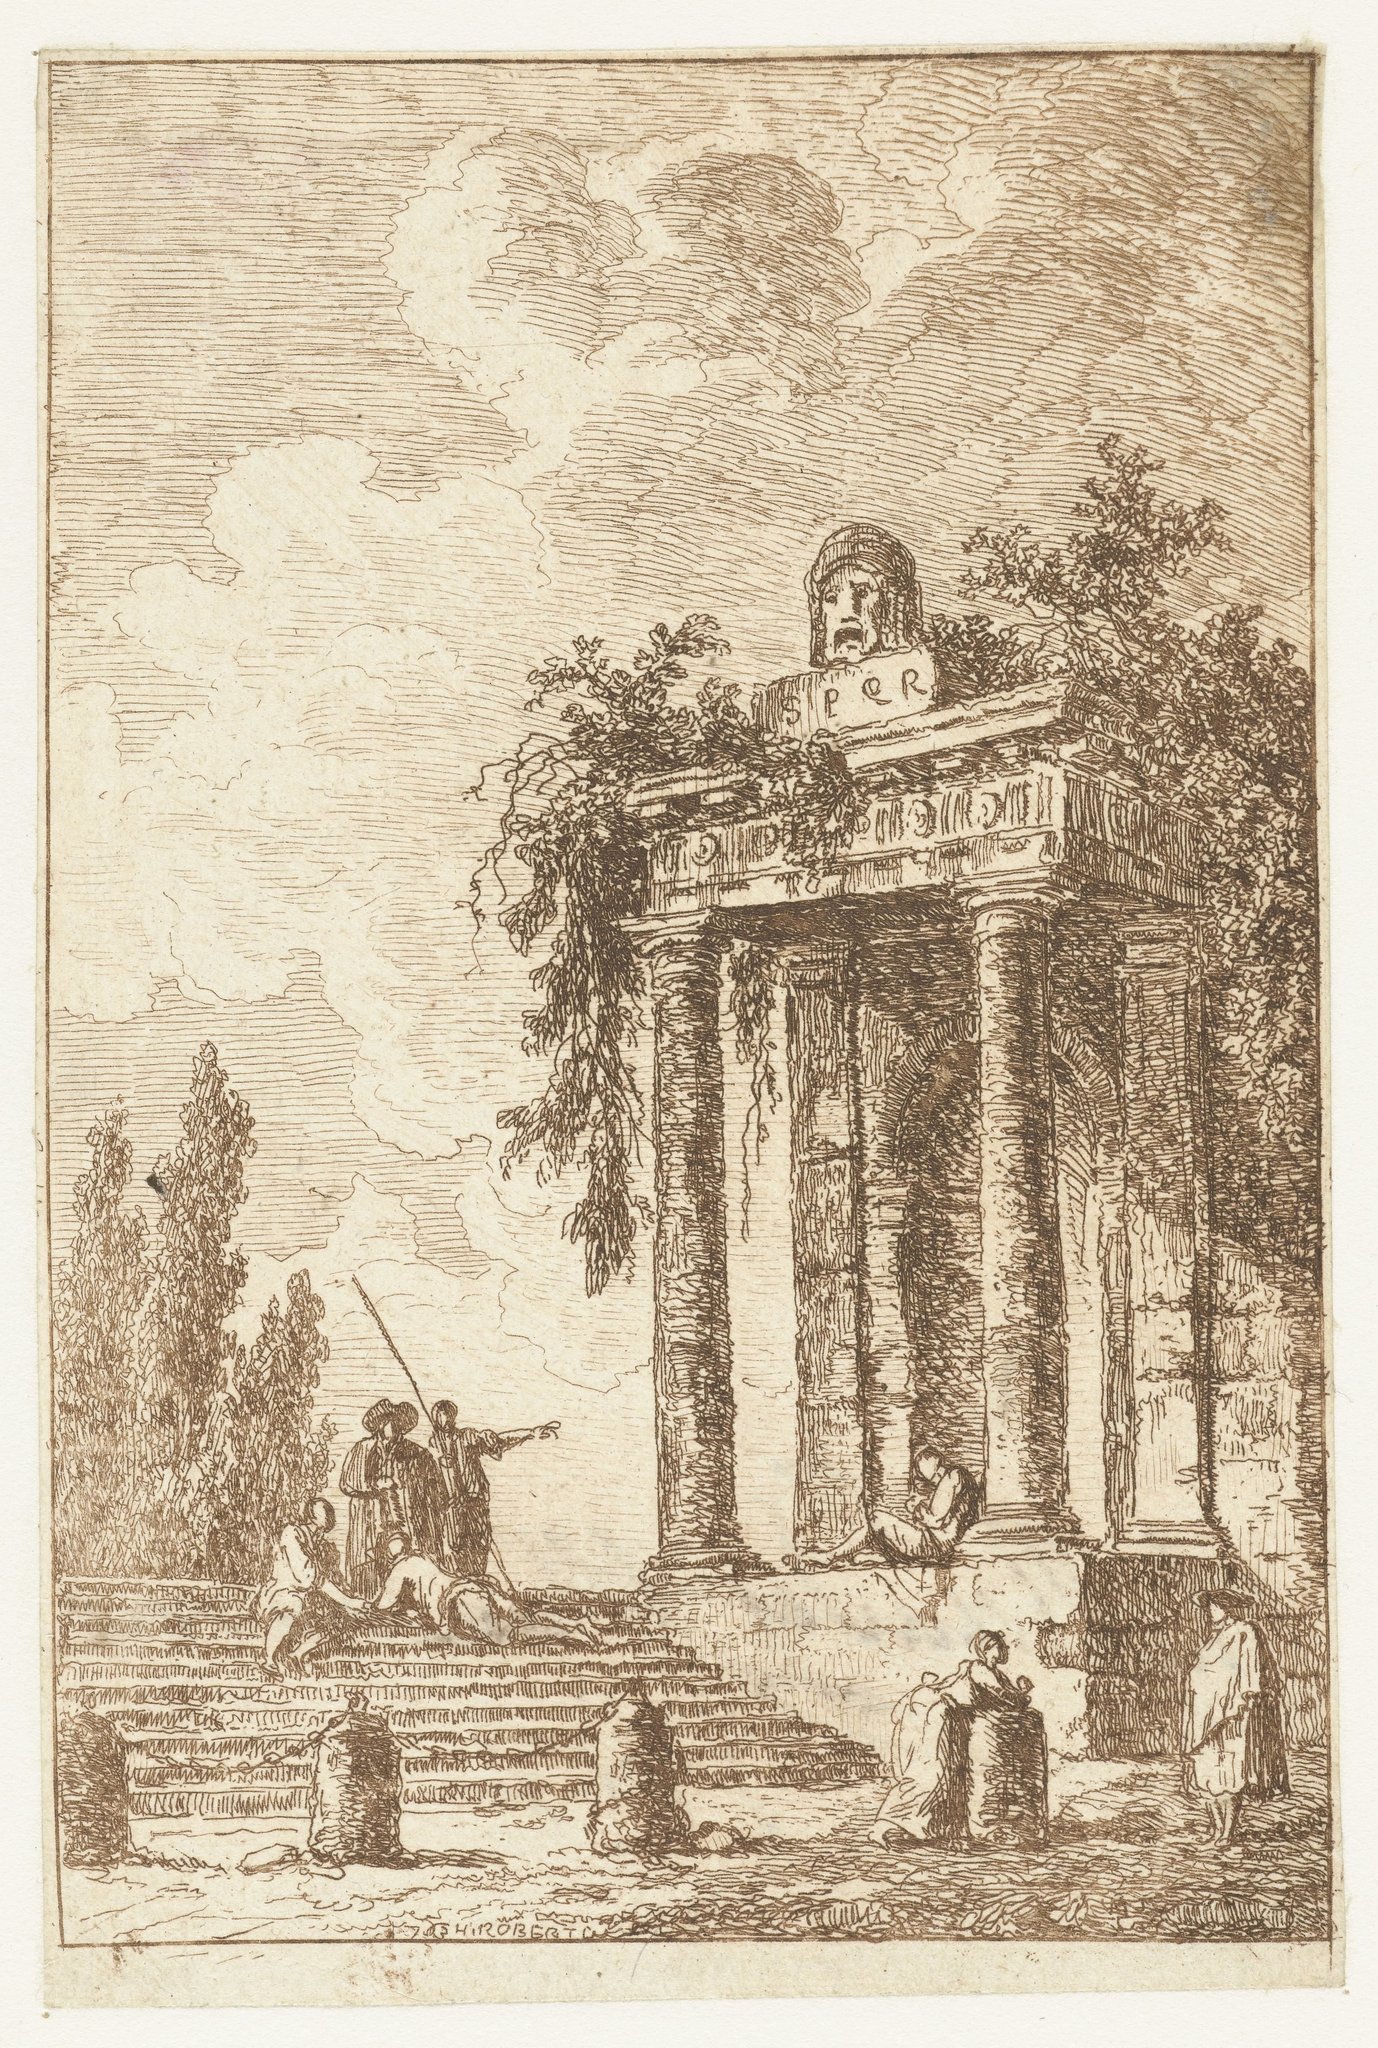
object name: print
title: Romeinse gezichten`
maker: hubert robert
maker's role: draughtsman, print maker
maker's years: 1733-1808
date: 1763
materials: paper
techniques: etching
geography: rome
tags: ruin of a building ~ architecture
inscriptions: collector's mark: Lugt 2228, collector's mark: Lugt 1937, collector's mark: ‘Douane Centrale La Portation Paris’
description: Een groepje mensen bij een trap naast een overgroeide ruïne van een Romeins gebouw. Vierde prent uit een serie van tien.